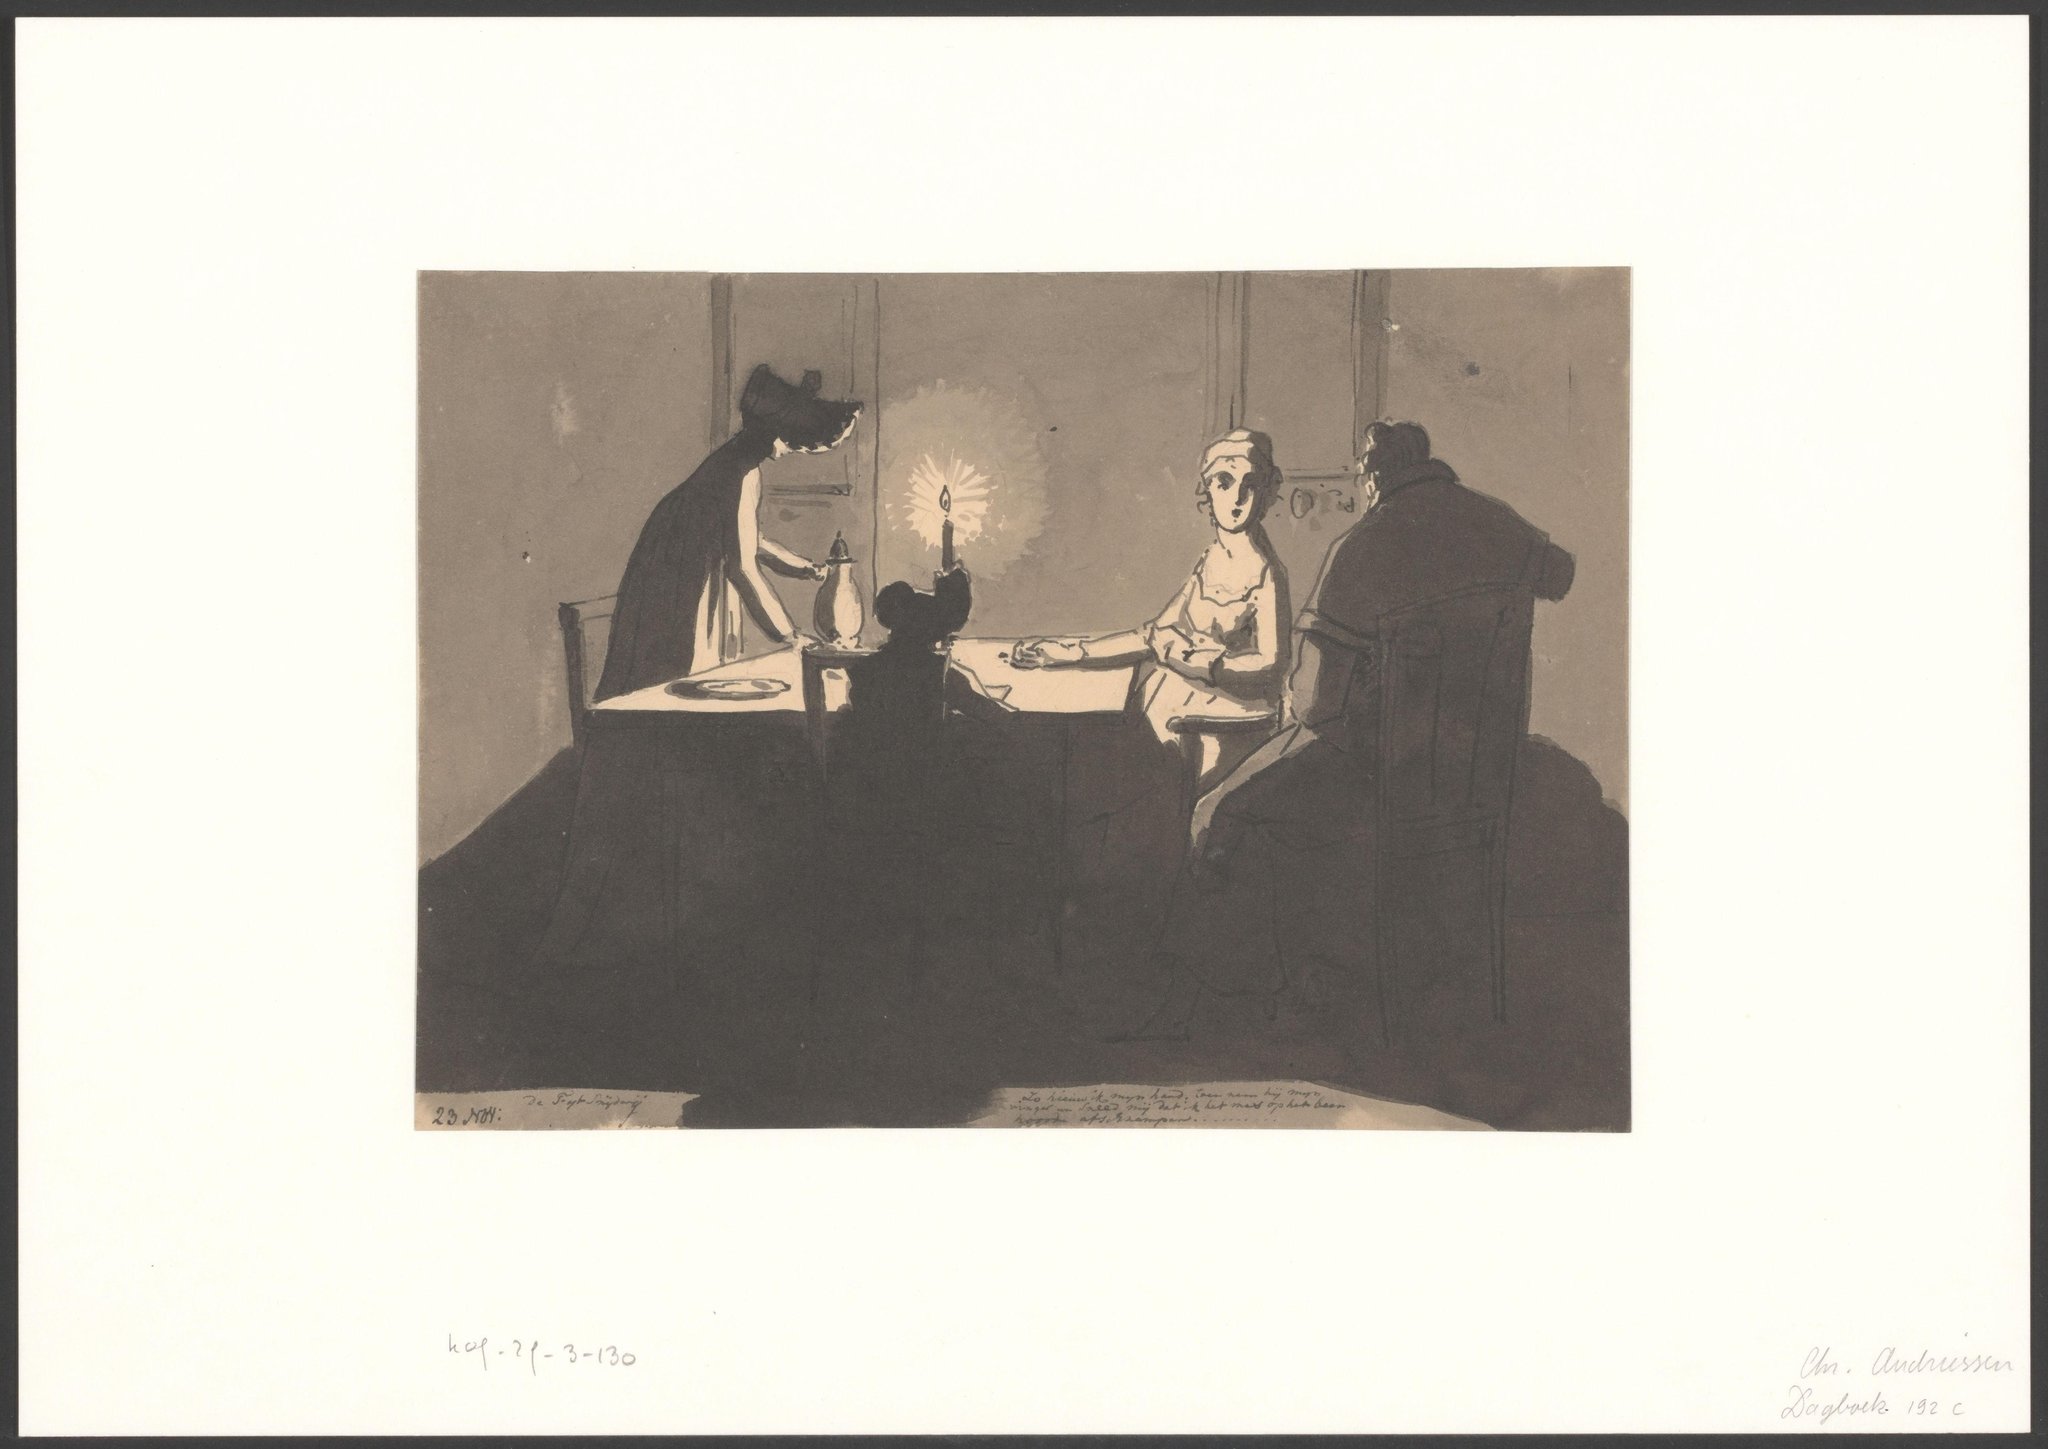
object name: print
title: Doortje legt uit hoe de fijtsnijder haar hand heeft geopereerd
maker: christiaan andriessen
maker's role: draughtsman, print maker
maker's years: 1775-1846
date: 1806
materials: ink, paper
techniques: brush, pen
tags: amsterdam, print maker, draughtsman, christiaan andriessen, medical examination, medical treatment, candlestick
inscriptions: signature, inscription: ‘23 nov: de fijtsnijderij / Zo hieuw ik mijn hand en toen nam hij mijn vinger en sneed mij dat ik het mes op het been hoorde afschrampen’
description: Gesprek tussen Christiaan Andriessen en twee vrouwen, onder wie zijn zuster Doortje. Kelet luistert mee naar het verhaal over het verwijderen van fijt.